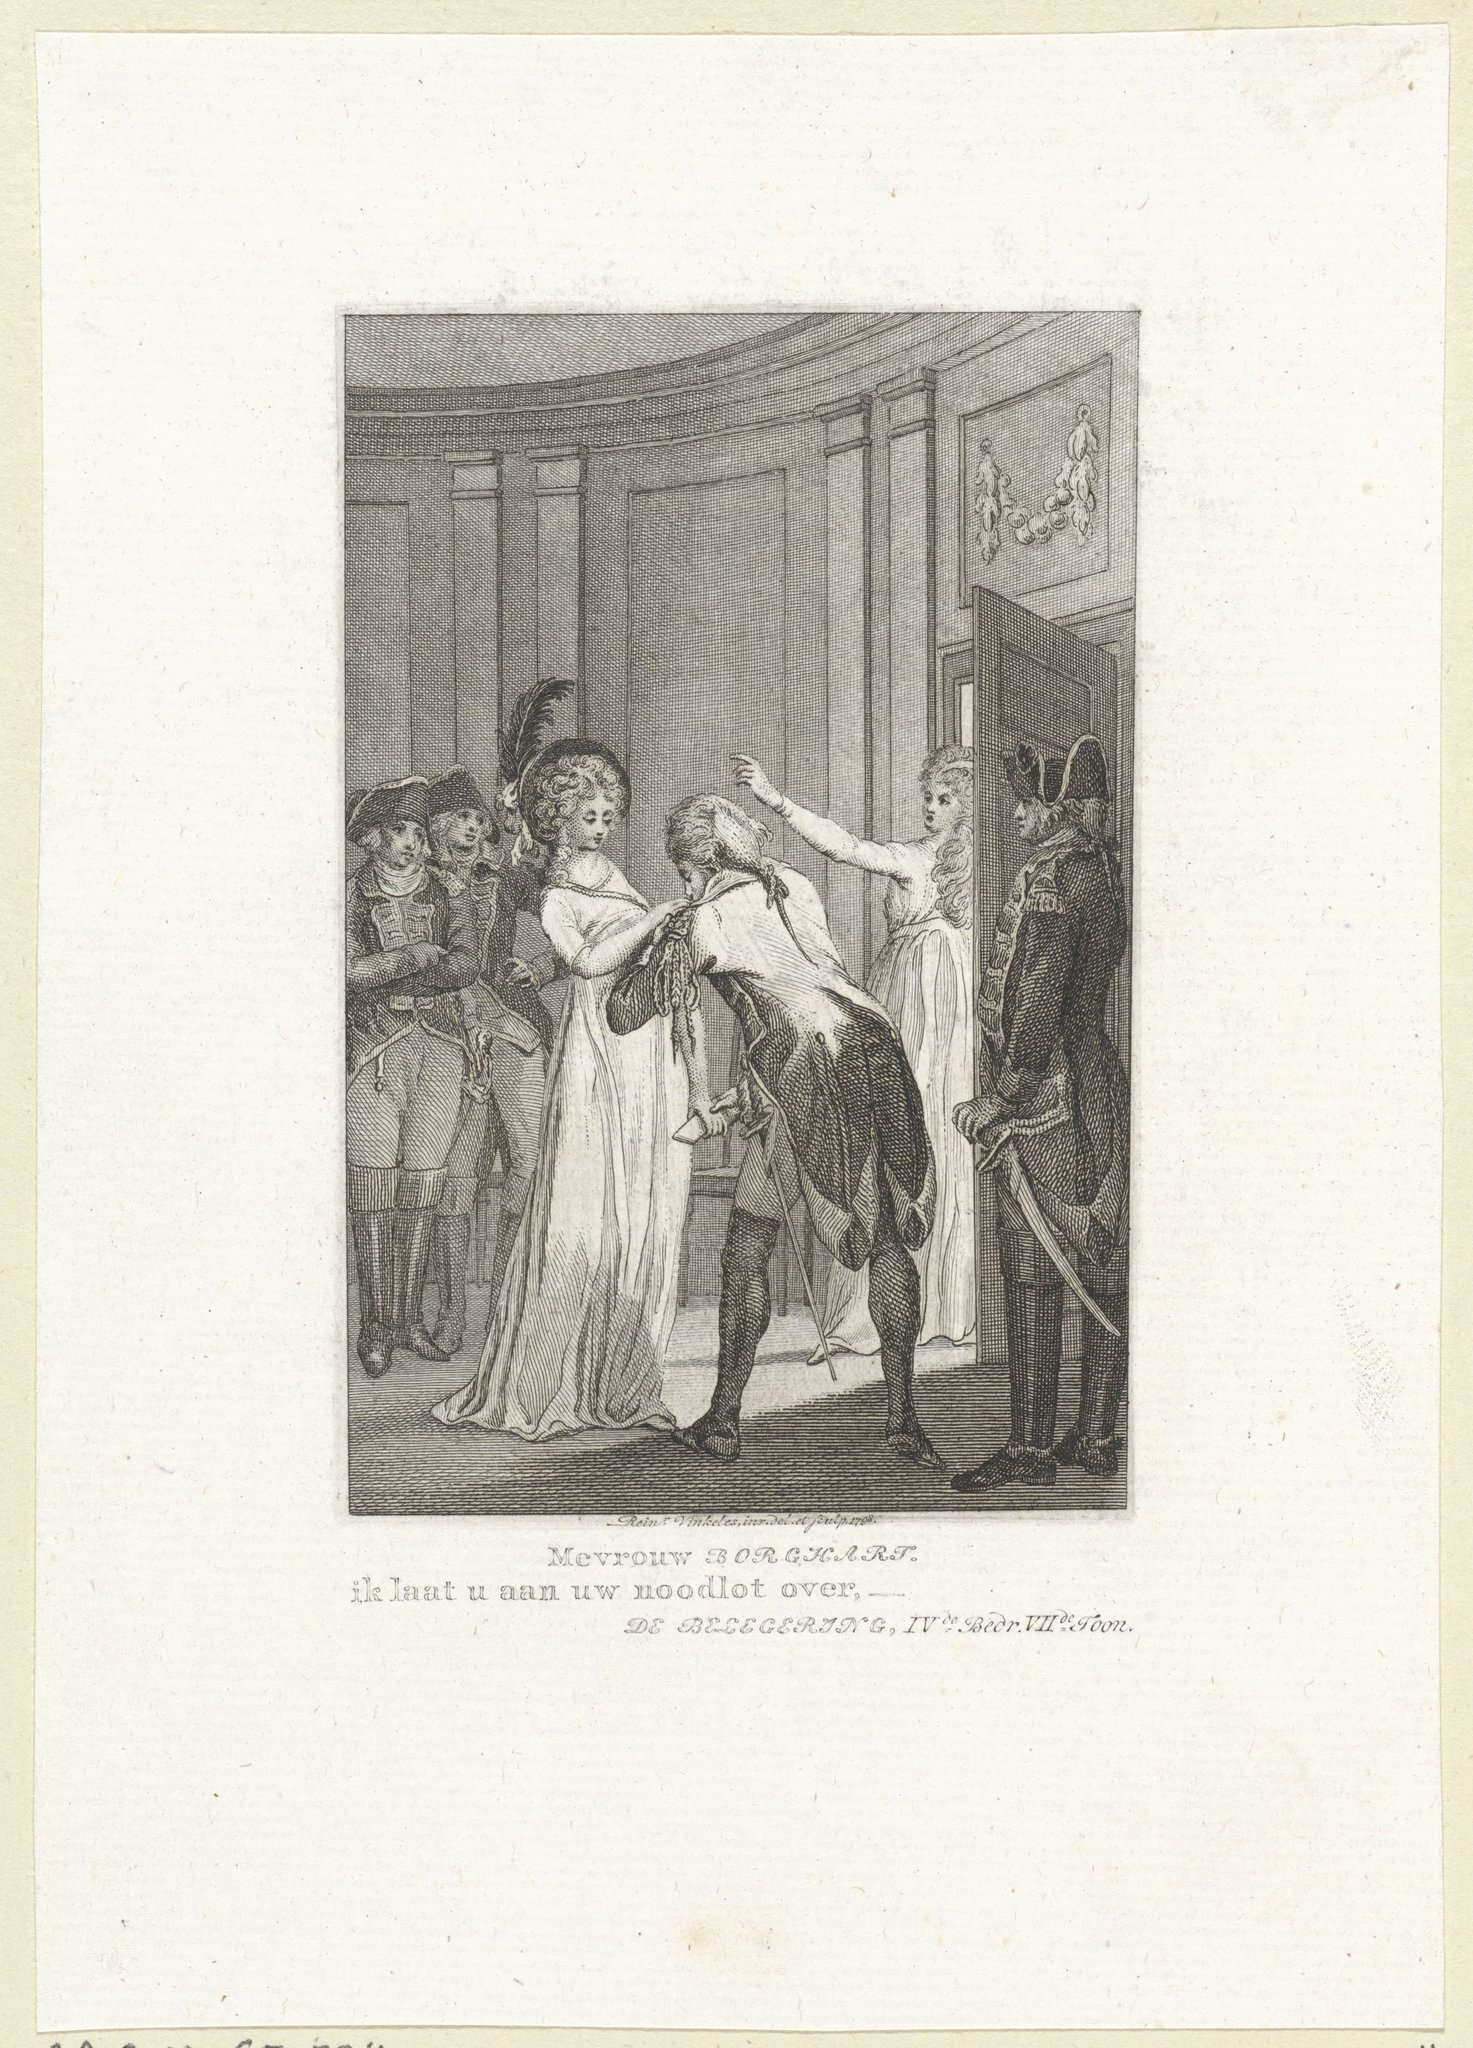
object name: print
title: Man kust een vrouw op haar hand terwijl zij hem een brief geeft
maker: reinier vinkeles (i)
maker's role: draughtsman, print maker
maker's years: 1741-1816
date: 1798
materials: paper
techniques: engraving, etching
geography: amsterdam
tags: letter, envelope, kissing the hand (lovers), index finger forwards, pointing, indicating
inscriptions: collector's mark: Lugt 240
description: Deze prent is mogelijk ook gebruikt als illustratie in: Kretschmar, F. De Belegering. Amsterdam: erven van Pieter Meĳer en Gerrit Warnars, 1798.